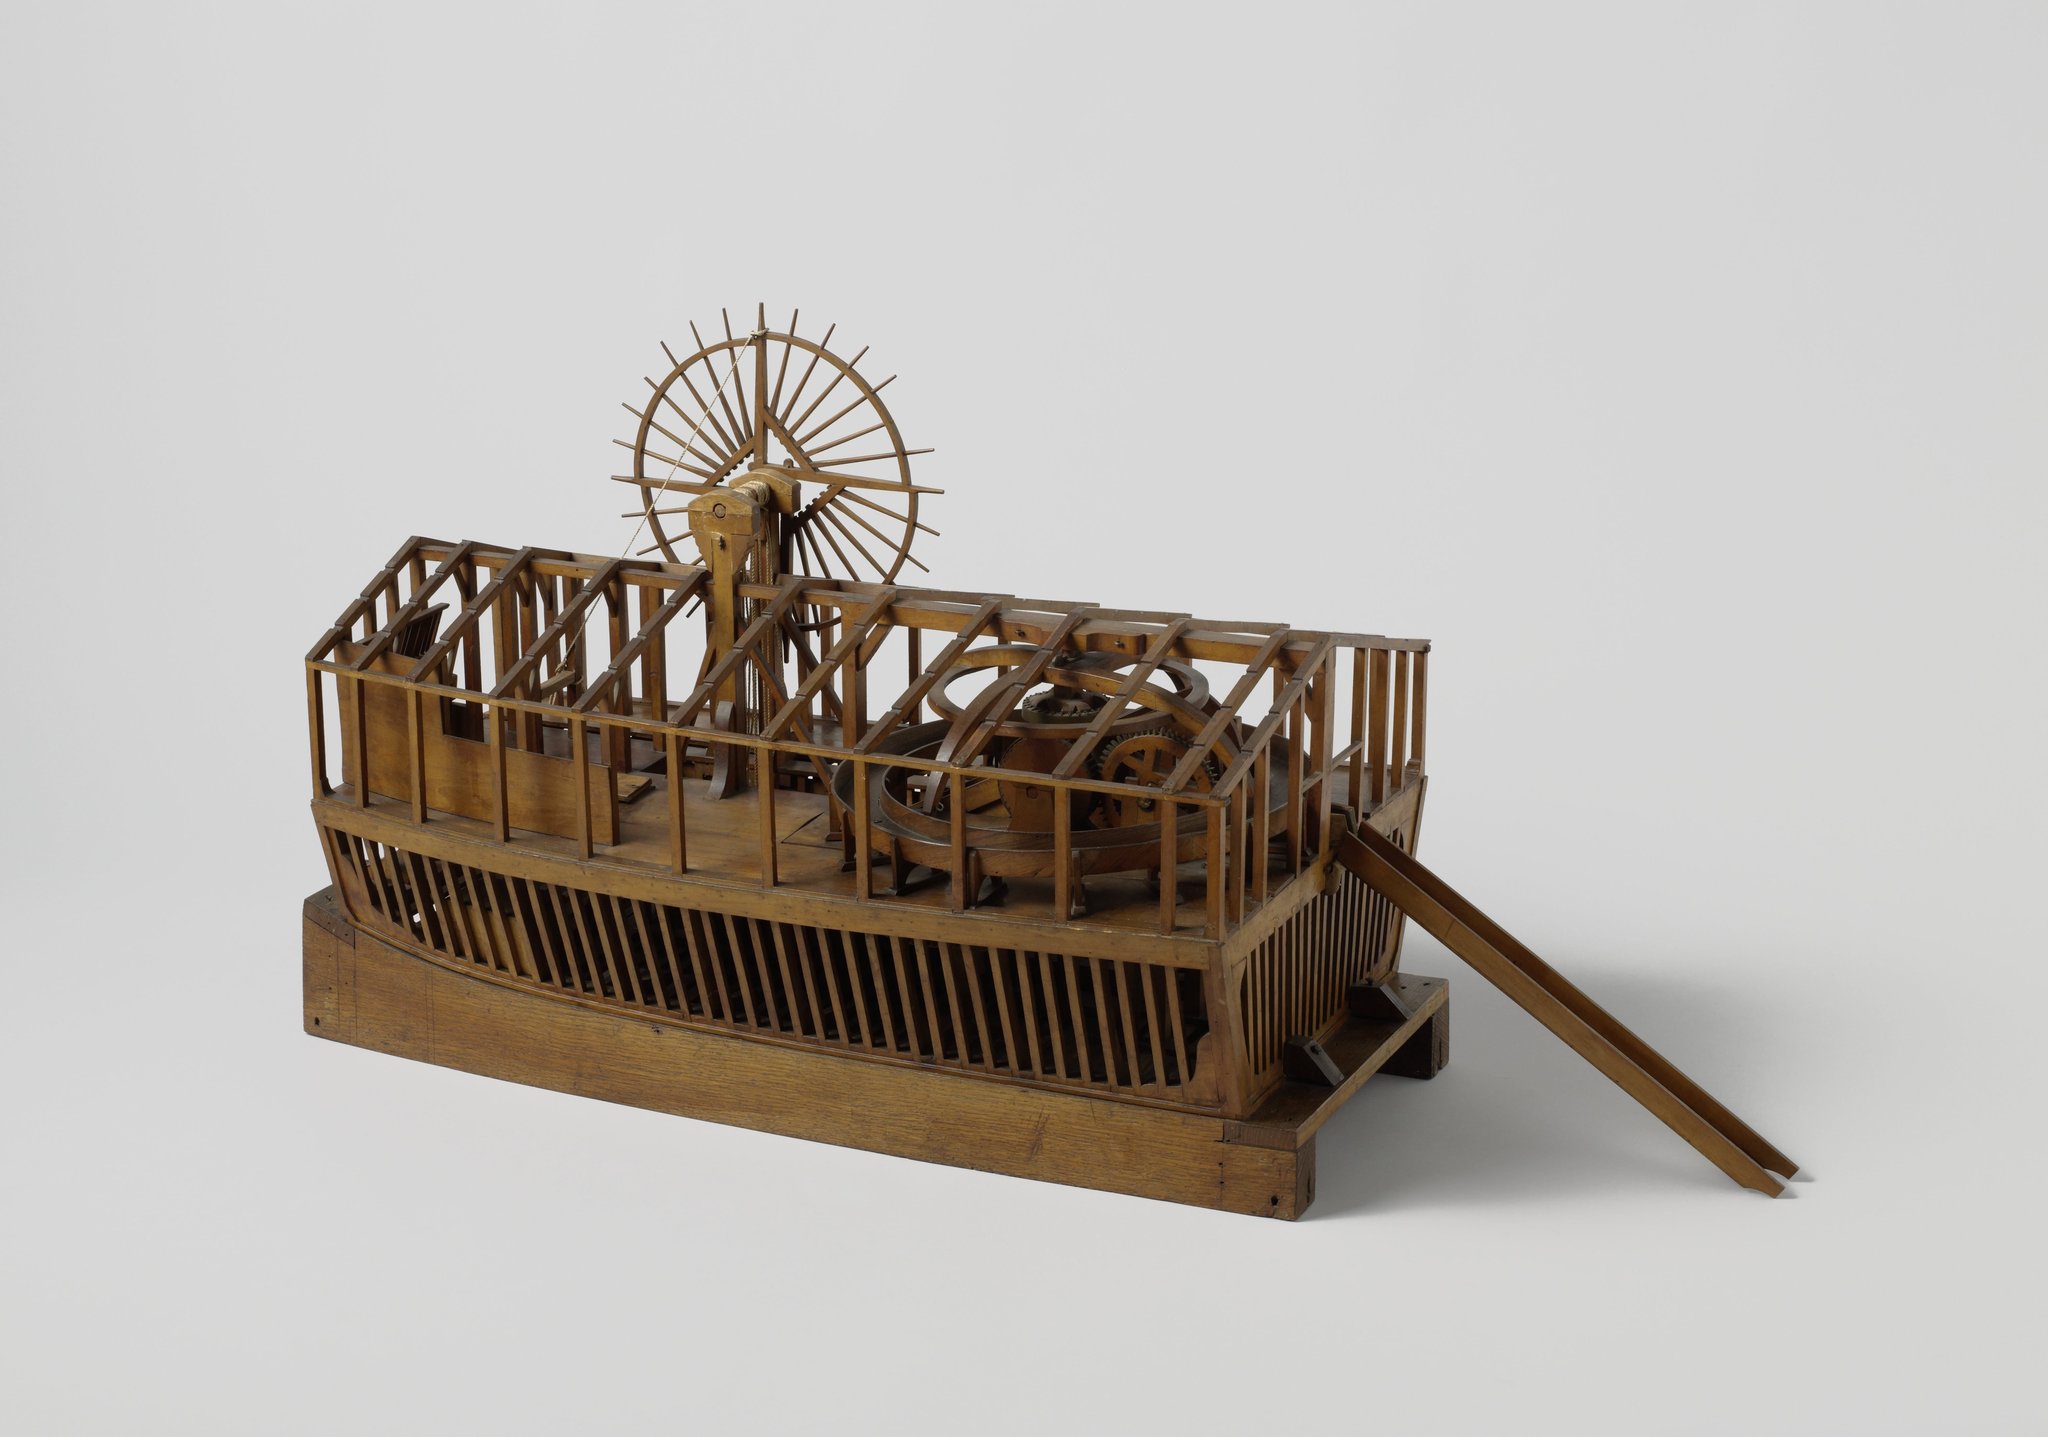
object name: ship model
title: Model of a Dredger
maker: Anonymous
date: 1800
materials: wood, brass, fiber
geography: netherlands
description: Dutch rivers and harbours constantly silt up as a result of sand carried in the water building up on the riverbed or harbour floor. Regular dredging is required to prevent waterways from becoming too shallow. Around 1800 much of this dredging was done by horse-driven mills. These ‘horse mills’ drove a chain with dippers that scooped up the mud and silt. On the front deck of this model are the stalls for the horses.